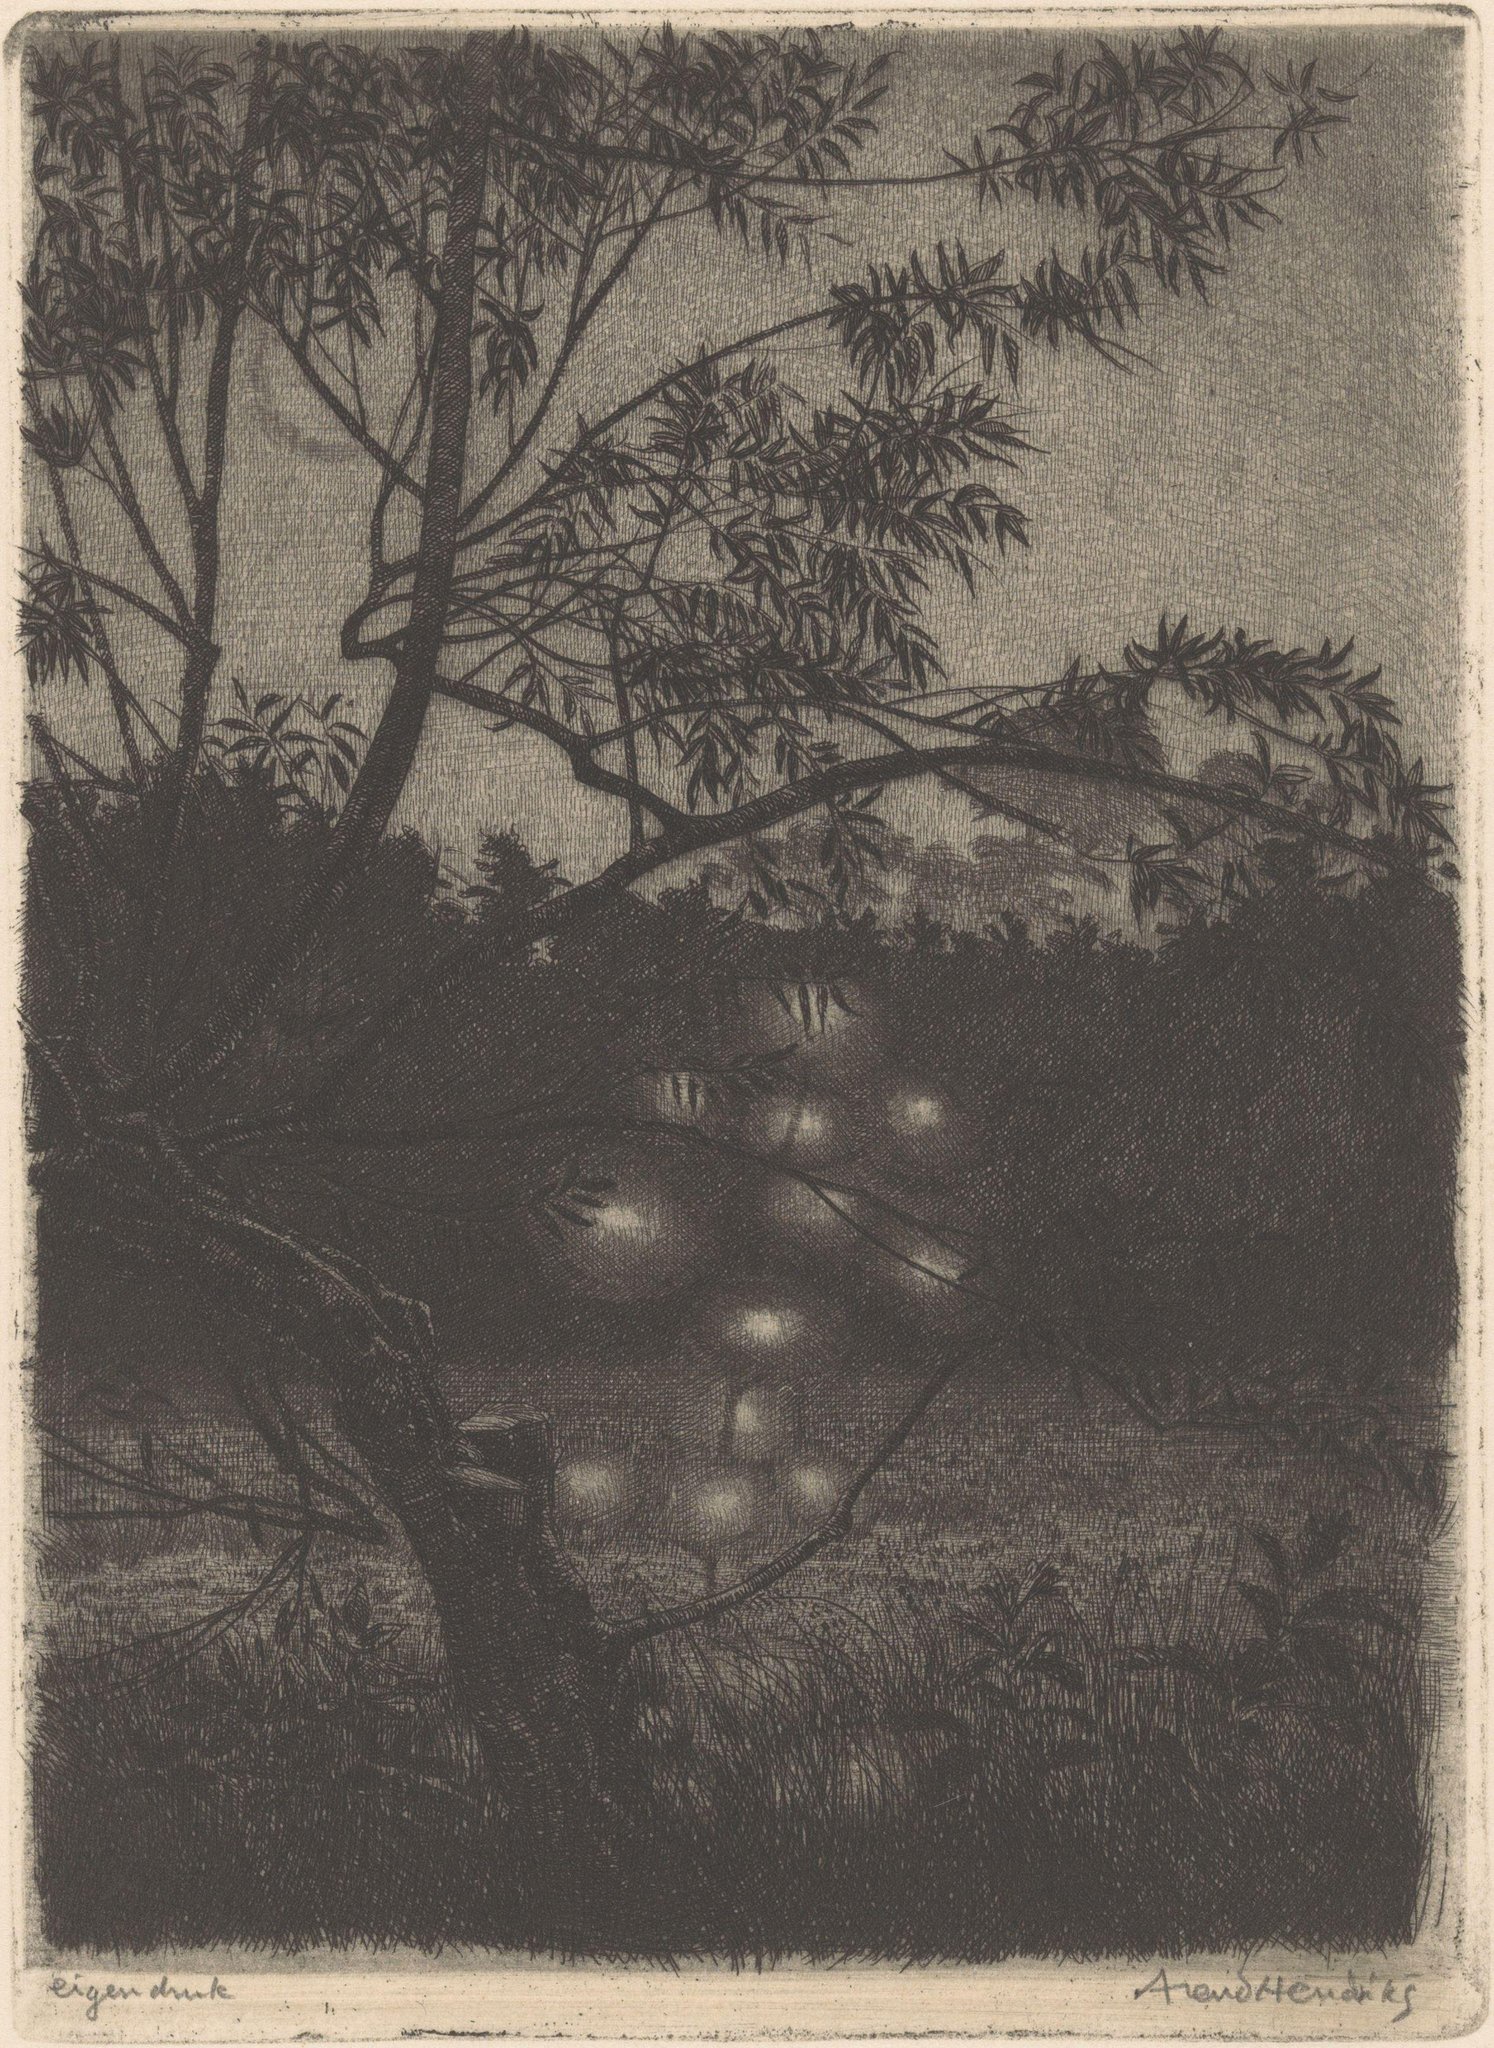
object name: print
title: Tuin met lichtgevende boom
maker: arend hendriks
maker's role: print maker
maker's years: 1901-1951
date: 1911-1943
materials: paper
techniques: etching, intaglio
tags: trees, light, night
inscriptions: collector's mark: Lugt 2228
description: Door de takken van een wilg zicht op een andere boom die op twaalf plekken licht lijkt te geven, wellicht door een zwerm vuurvliegen.